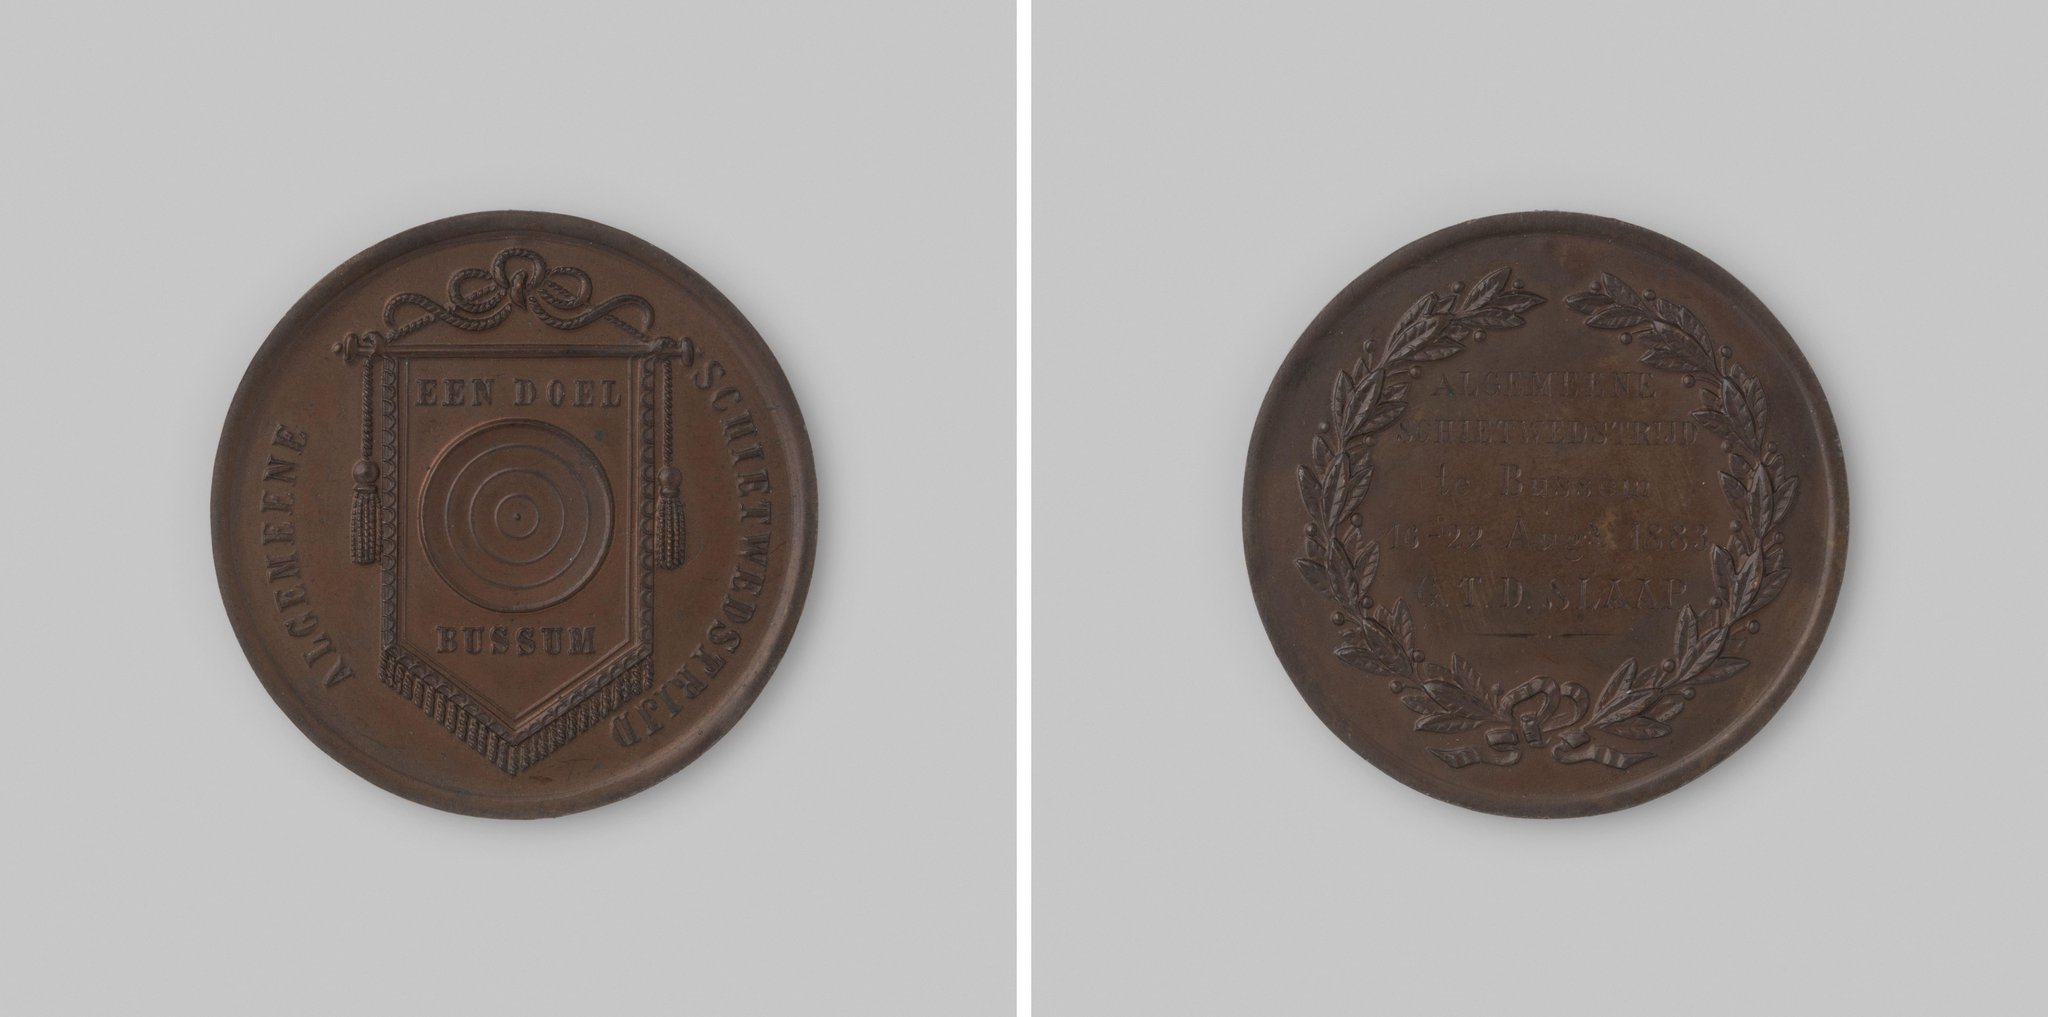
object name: draagpenning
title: Prijspenning van de scherpschutters-weerbaarheidsvereeniging Een Doel te Bussum, derde prijs voor Individueel-vuur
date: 1883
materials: bronze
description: Bronzen draagpenning met knop en ring. Voorzijde: banier met opschrift: EEN DOEL en daaronder: BUSSUM. Omschrift: ALGEMEENE SCHIETWEDSTRIJD. Keerzijde: beschreven veld met jaartal 1883, omgeven door lauwerkrans.